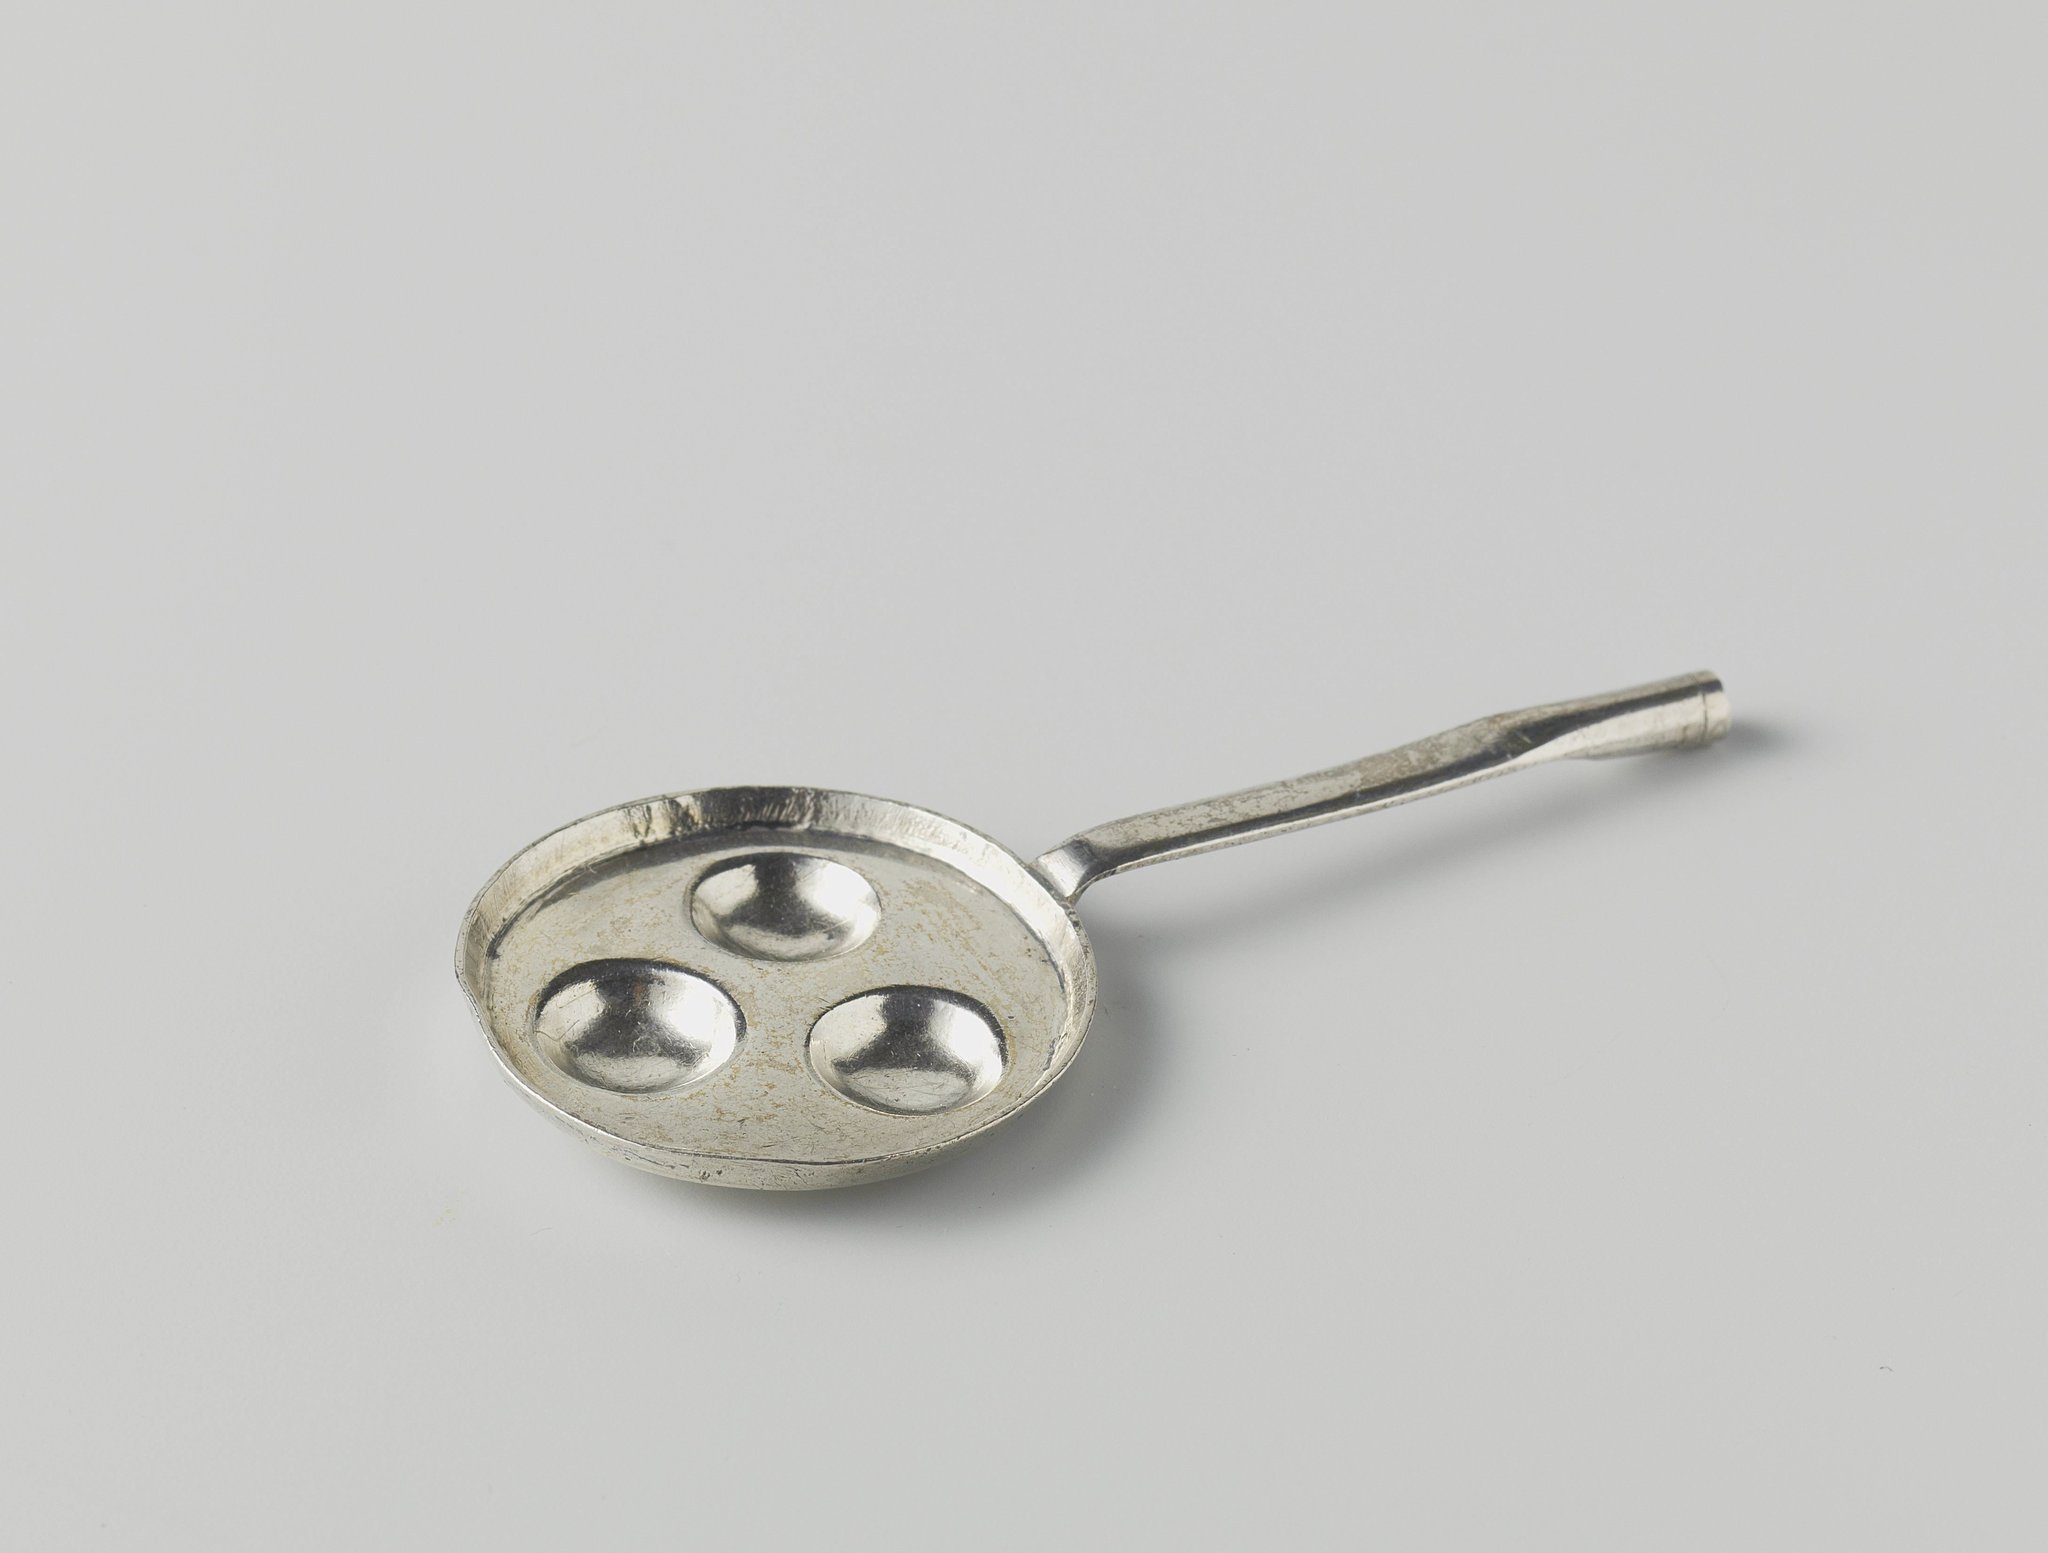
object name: miniature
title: Evenveeltjespan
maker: jan borduur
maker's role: silversmith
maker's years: 1698-1766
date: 1754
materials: silver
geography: amsterdam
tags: kitchen-utensils: frying pan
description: Evenveeltjespan met drie kuiltjes en een platte steel. De steel is aan het uiteinde hol, het houten handvat dat daarin past ontbreekt. De evenveeltjespan is gemerkt: stk.= Amsterdam, jrl.= U (1754), mt.= Jan Borduur.